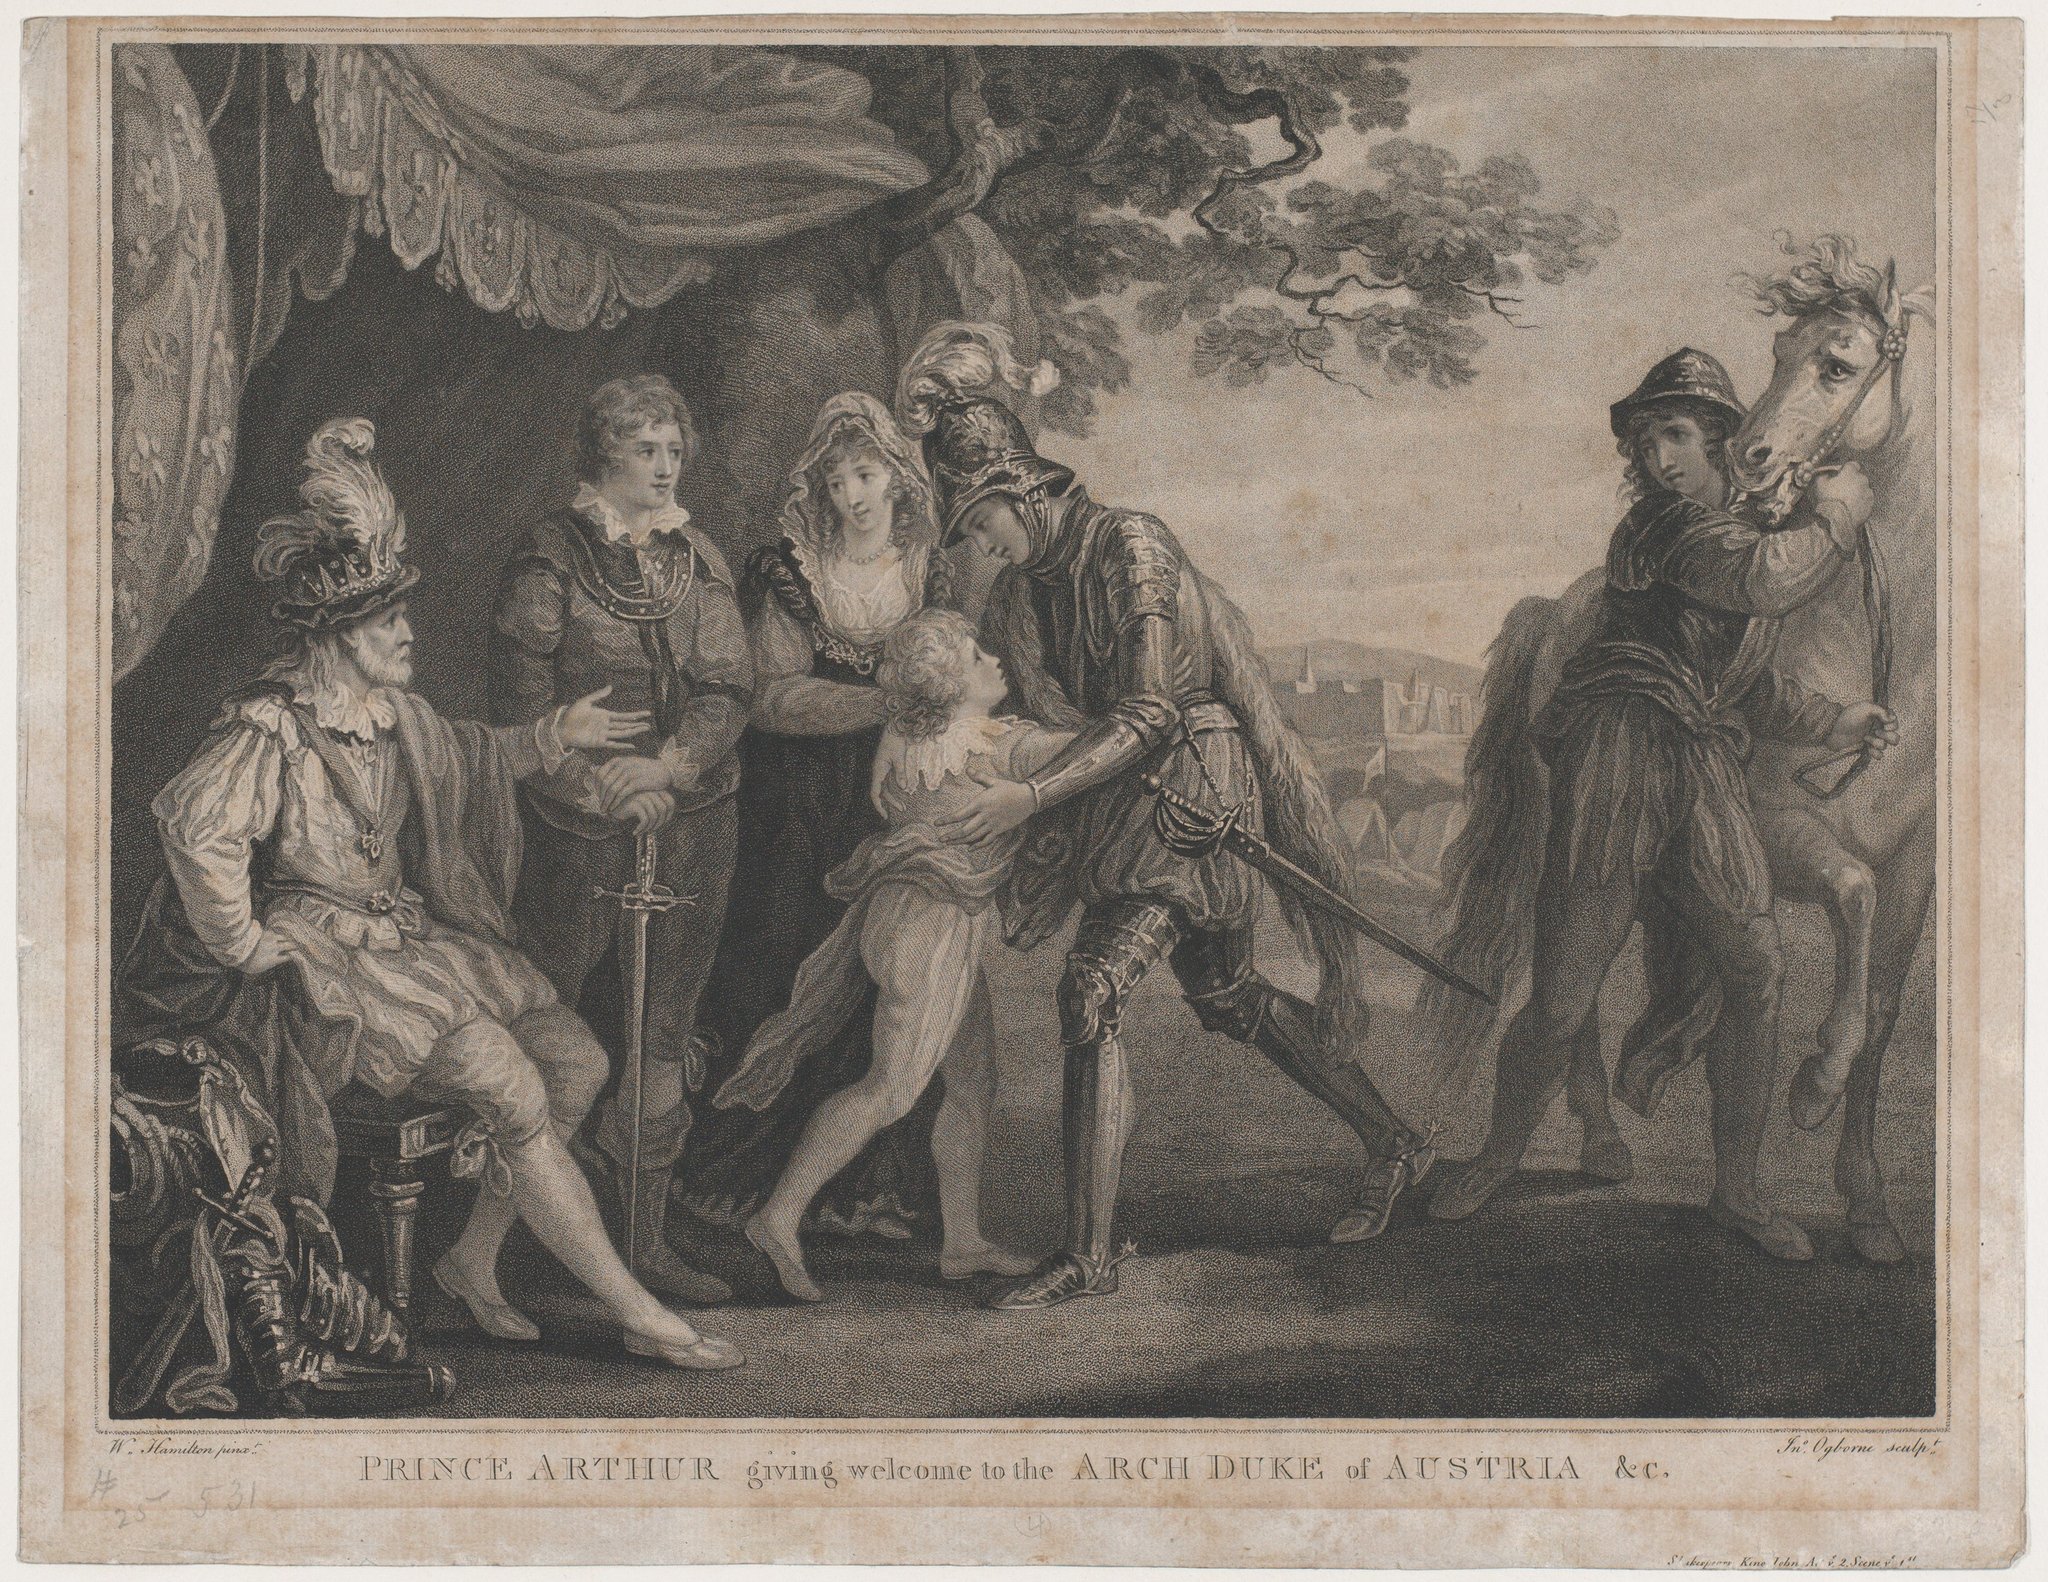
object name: print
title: Prince Arthur Giving Welcome to the Archduke of Austria, etc. (Shakespeare, King John, Act 2, Scene 1)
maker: john ogborne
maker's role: engraver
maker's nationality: british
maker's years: 1755-1837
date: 1791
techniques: engraving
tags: princes,shakespeare,women,horses